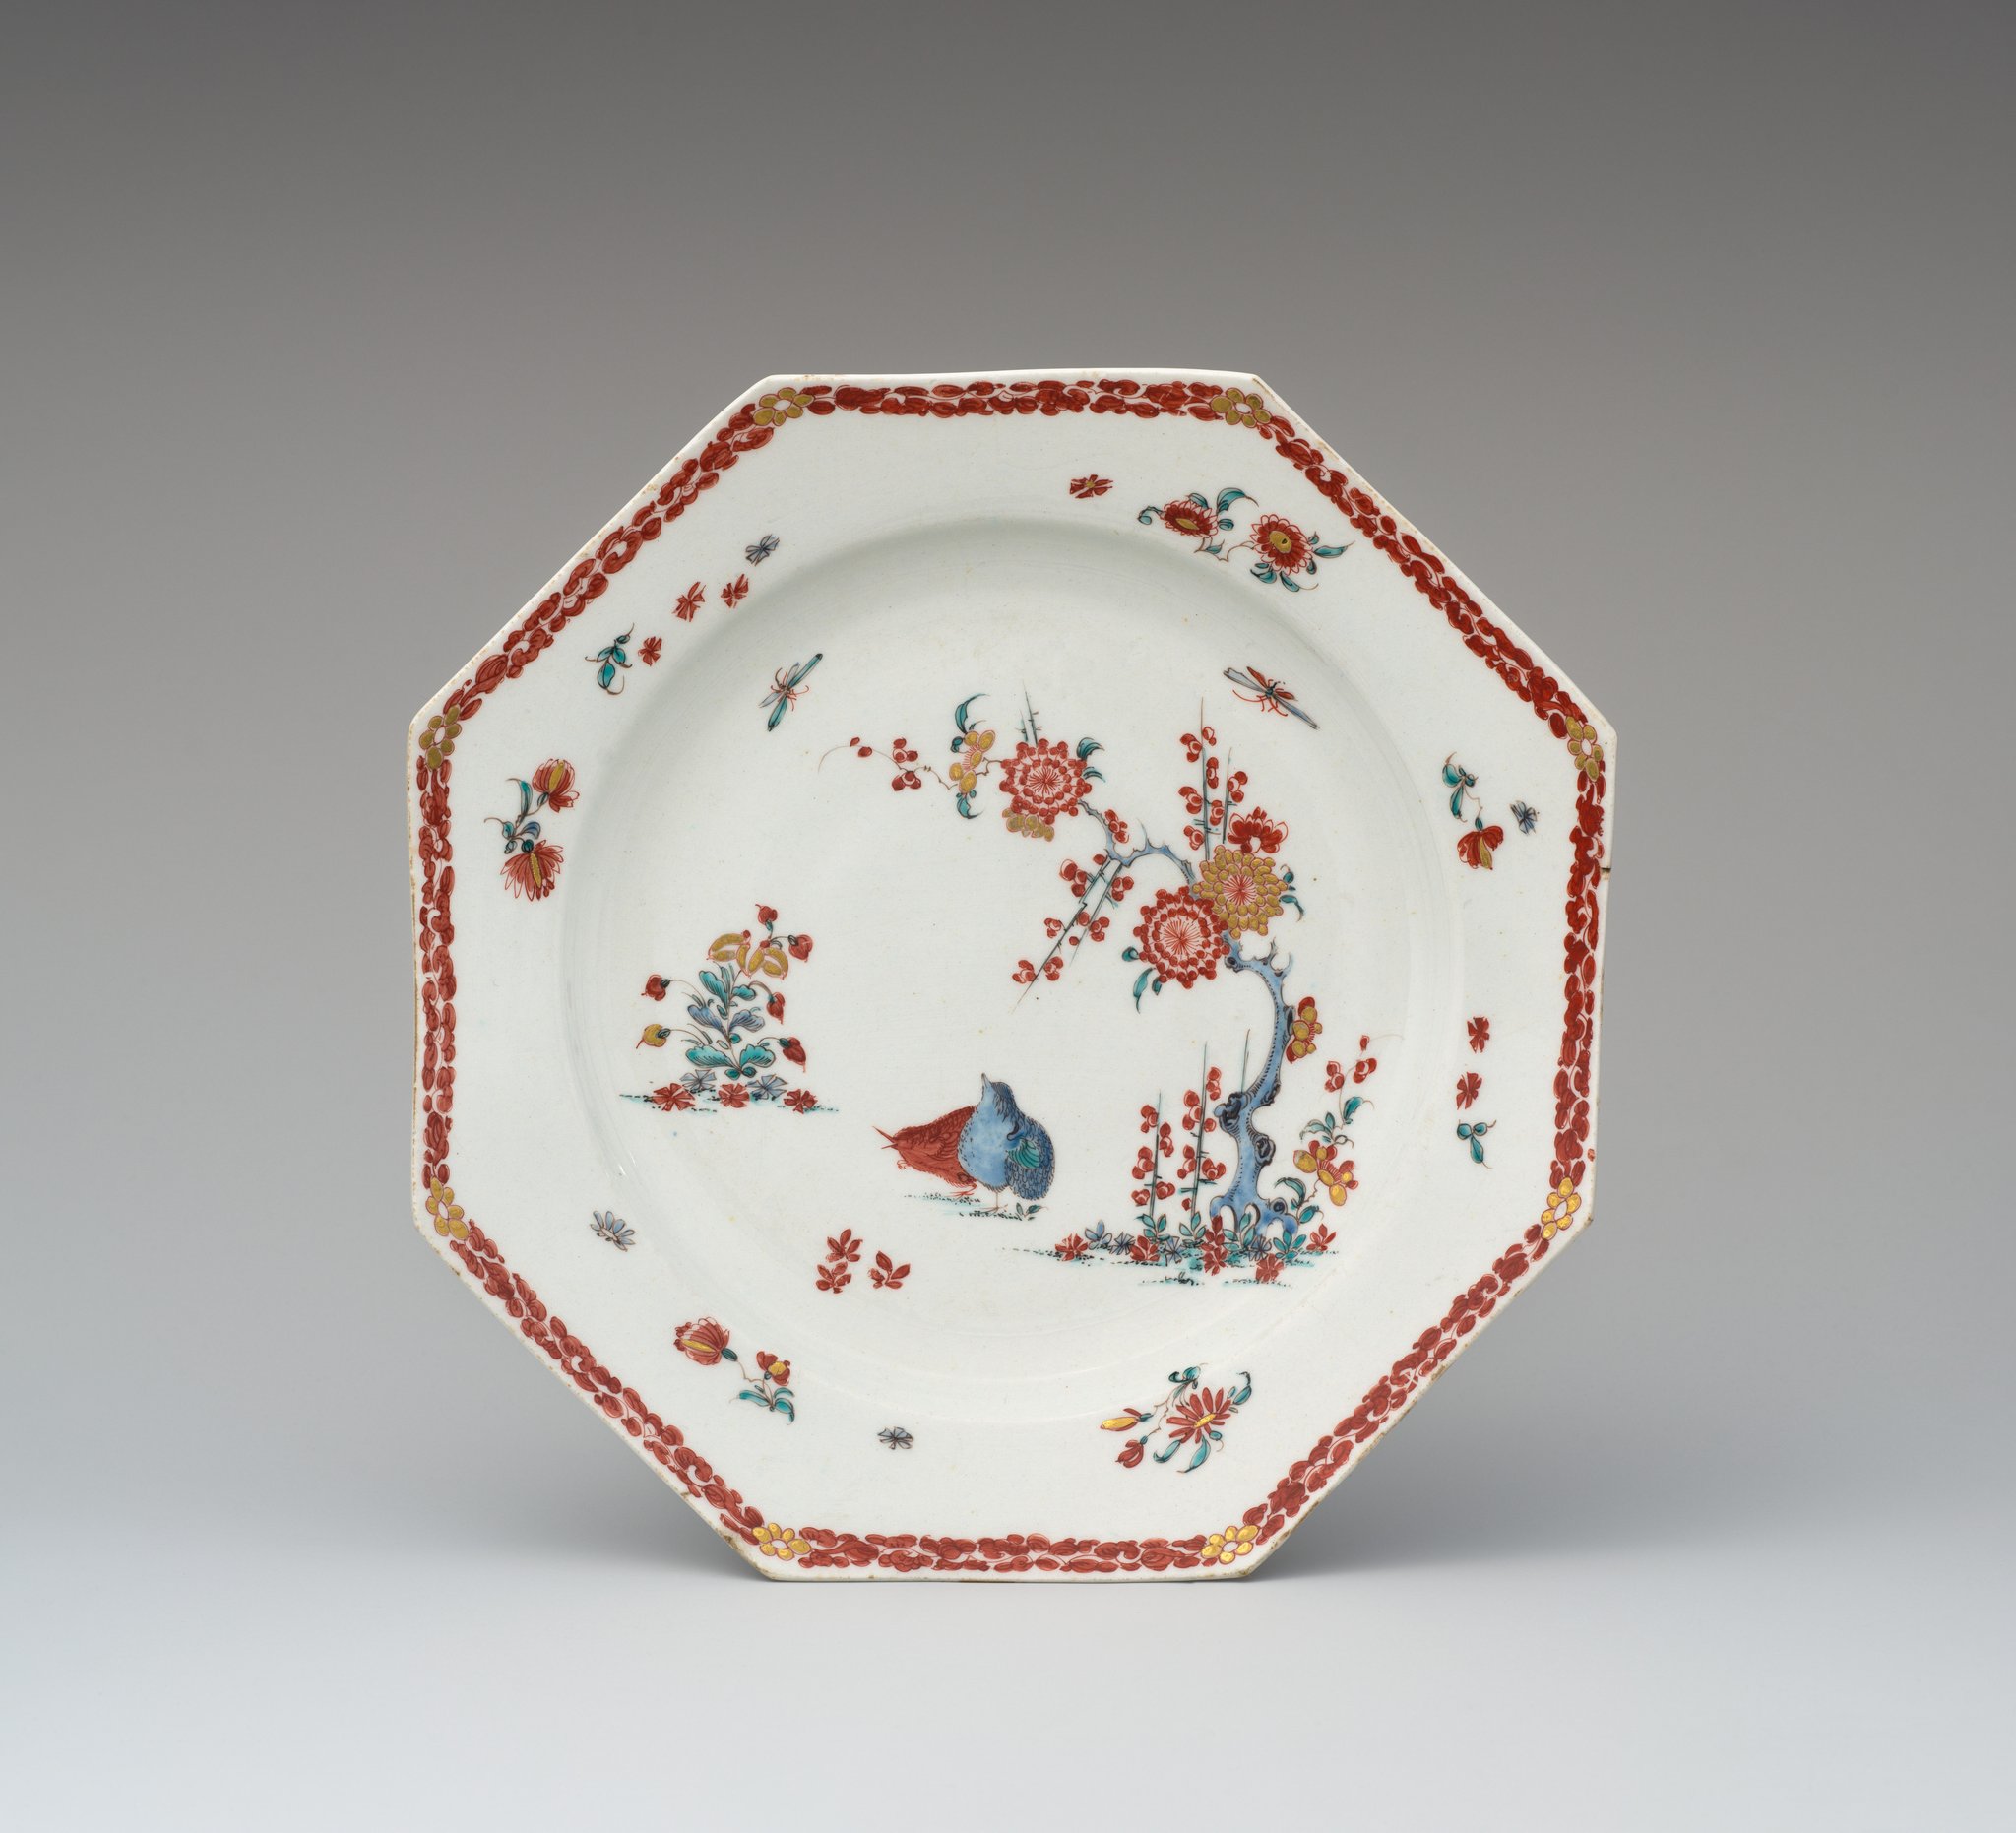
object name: plate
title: Plate with quail and peonies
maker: bow porcelain factory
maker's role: factory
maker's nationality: british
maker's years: 1747-1776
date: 1756-1758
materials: enamel, glaze, soft paste porcelain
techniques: painting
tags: birds,insects,peonies